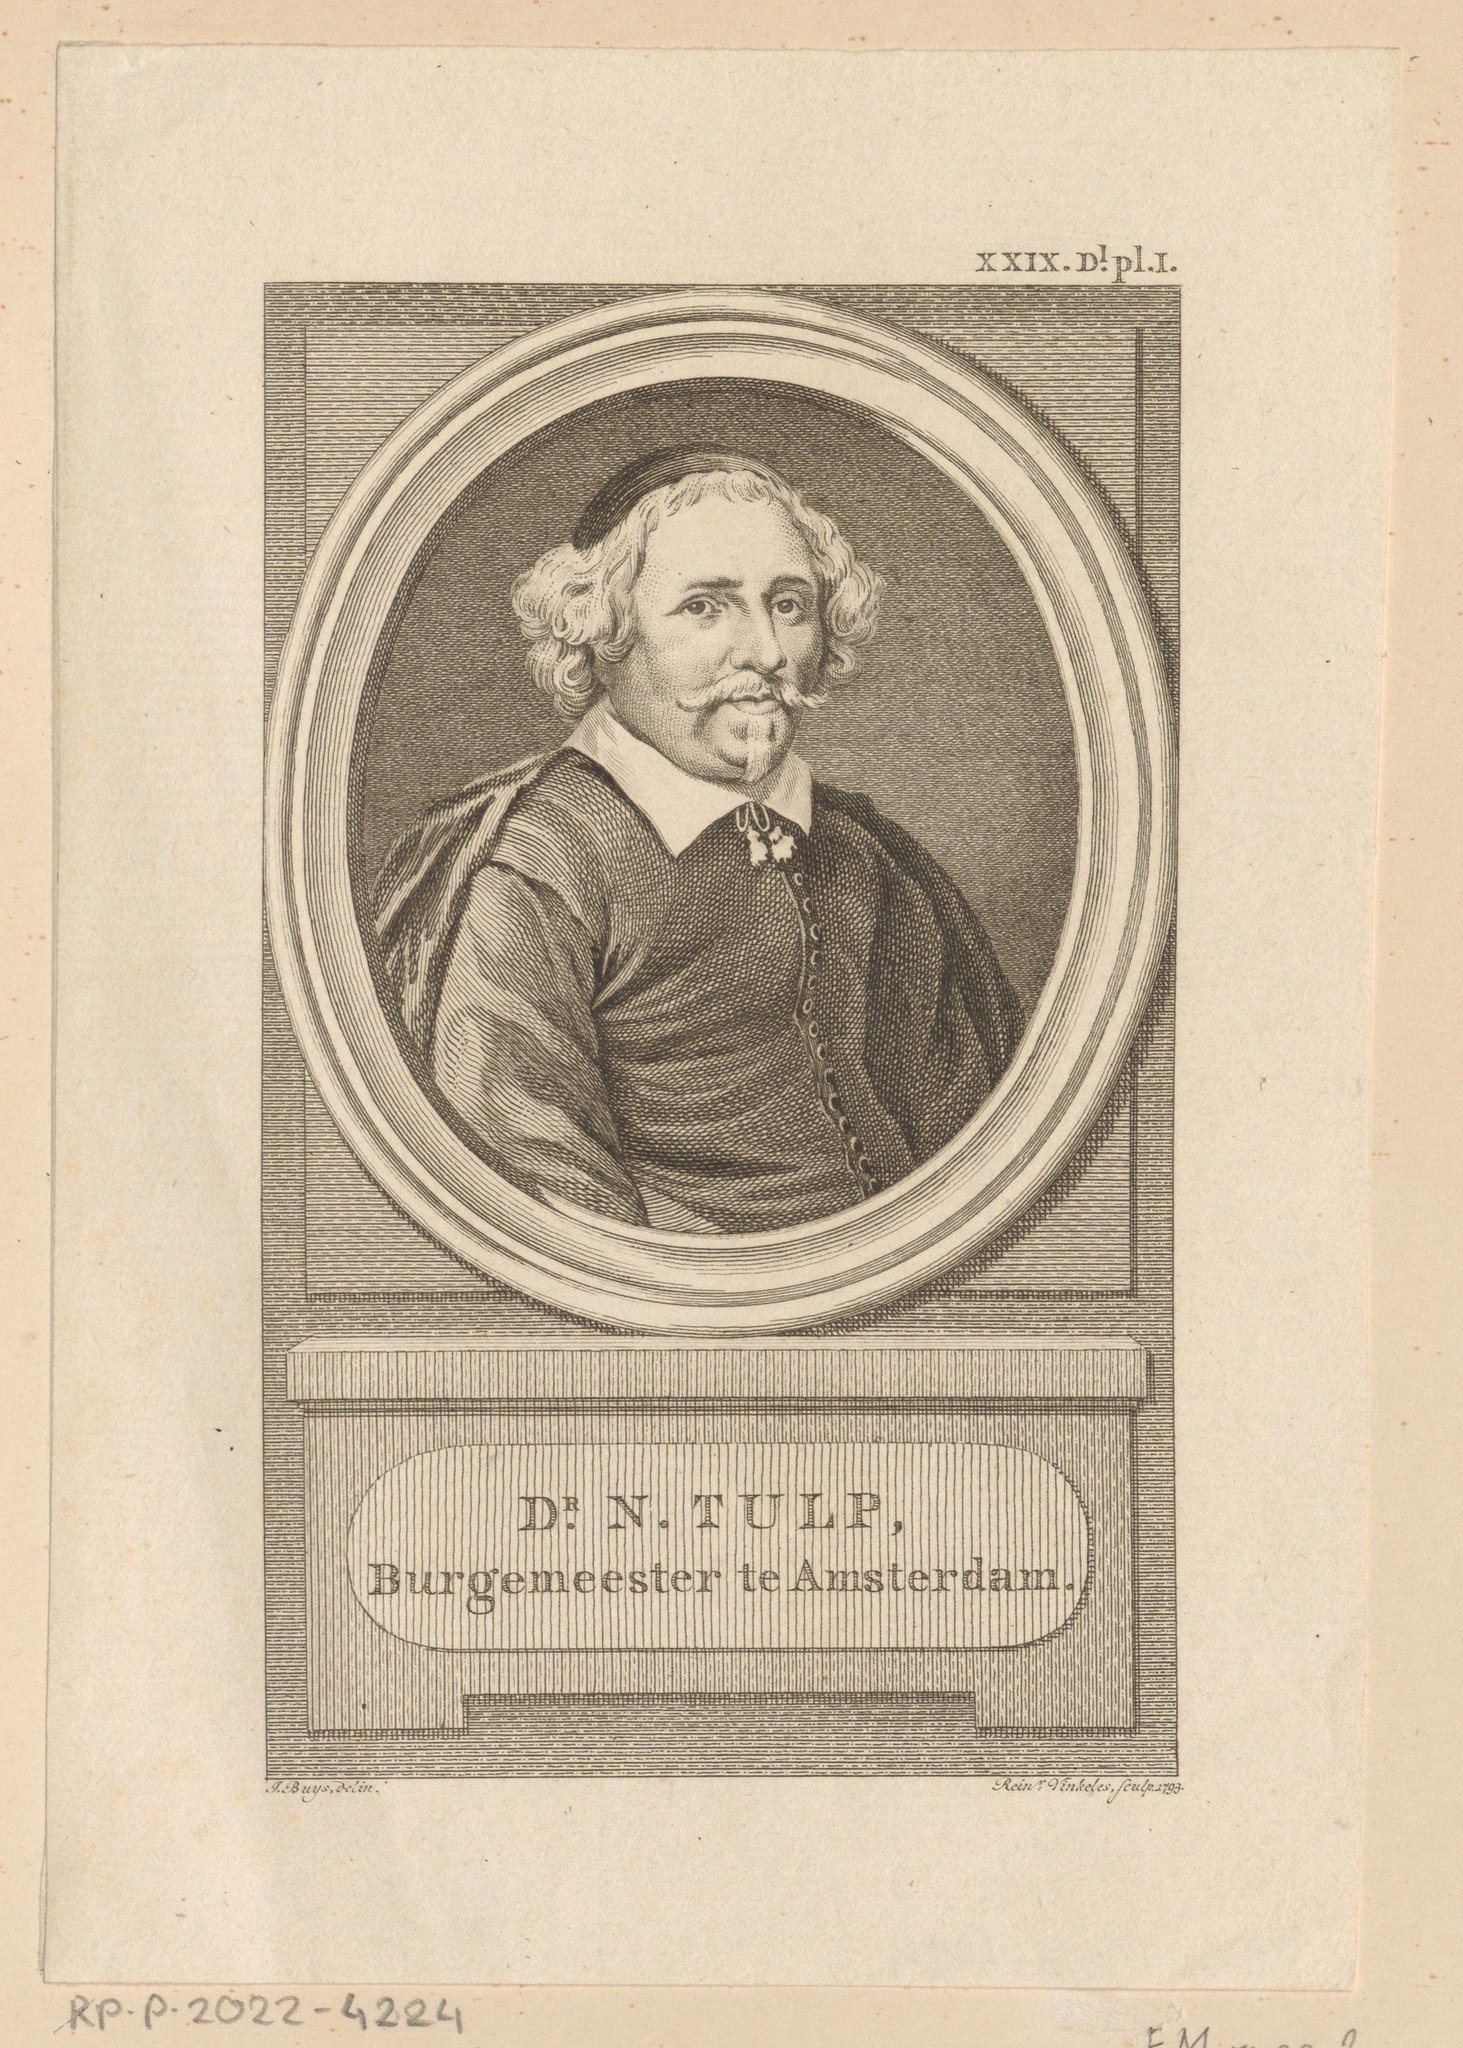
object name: print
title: Portret van Nicolaes Tulp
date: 1793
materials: paper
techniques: engraving, etching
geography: amsterdam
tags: the hague, mayor, historical persons, physician, doctor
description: Prent waarschijnlijk uit: Kok, Jacobus. Vaderlandsch woordenboek: met kaarten, plaaten en pourtraitten. Amsterdam: Johannes Allart, 1785-1796. Deel XXIX.